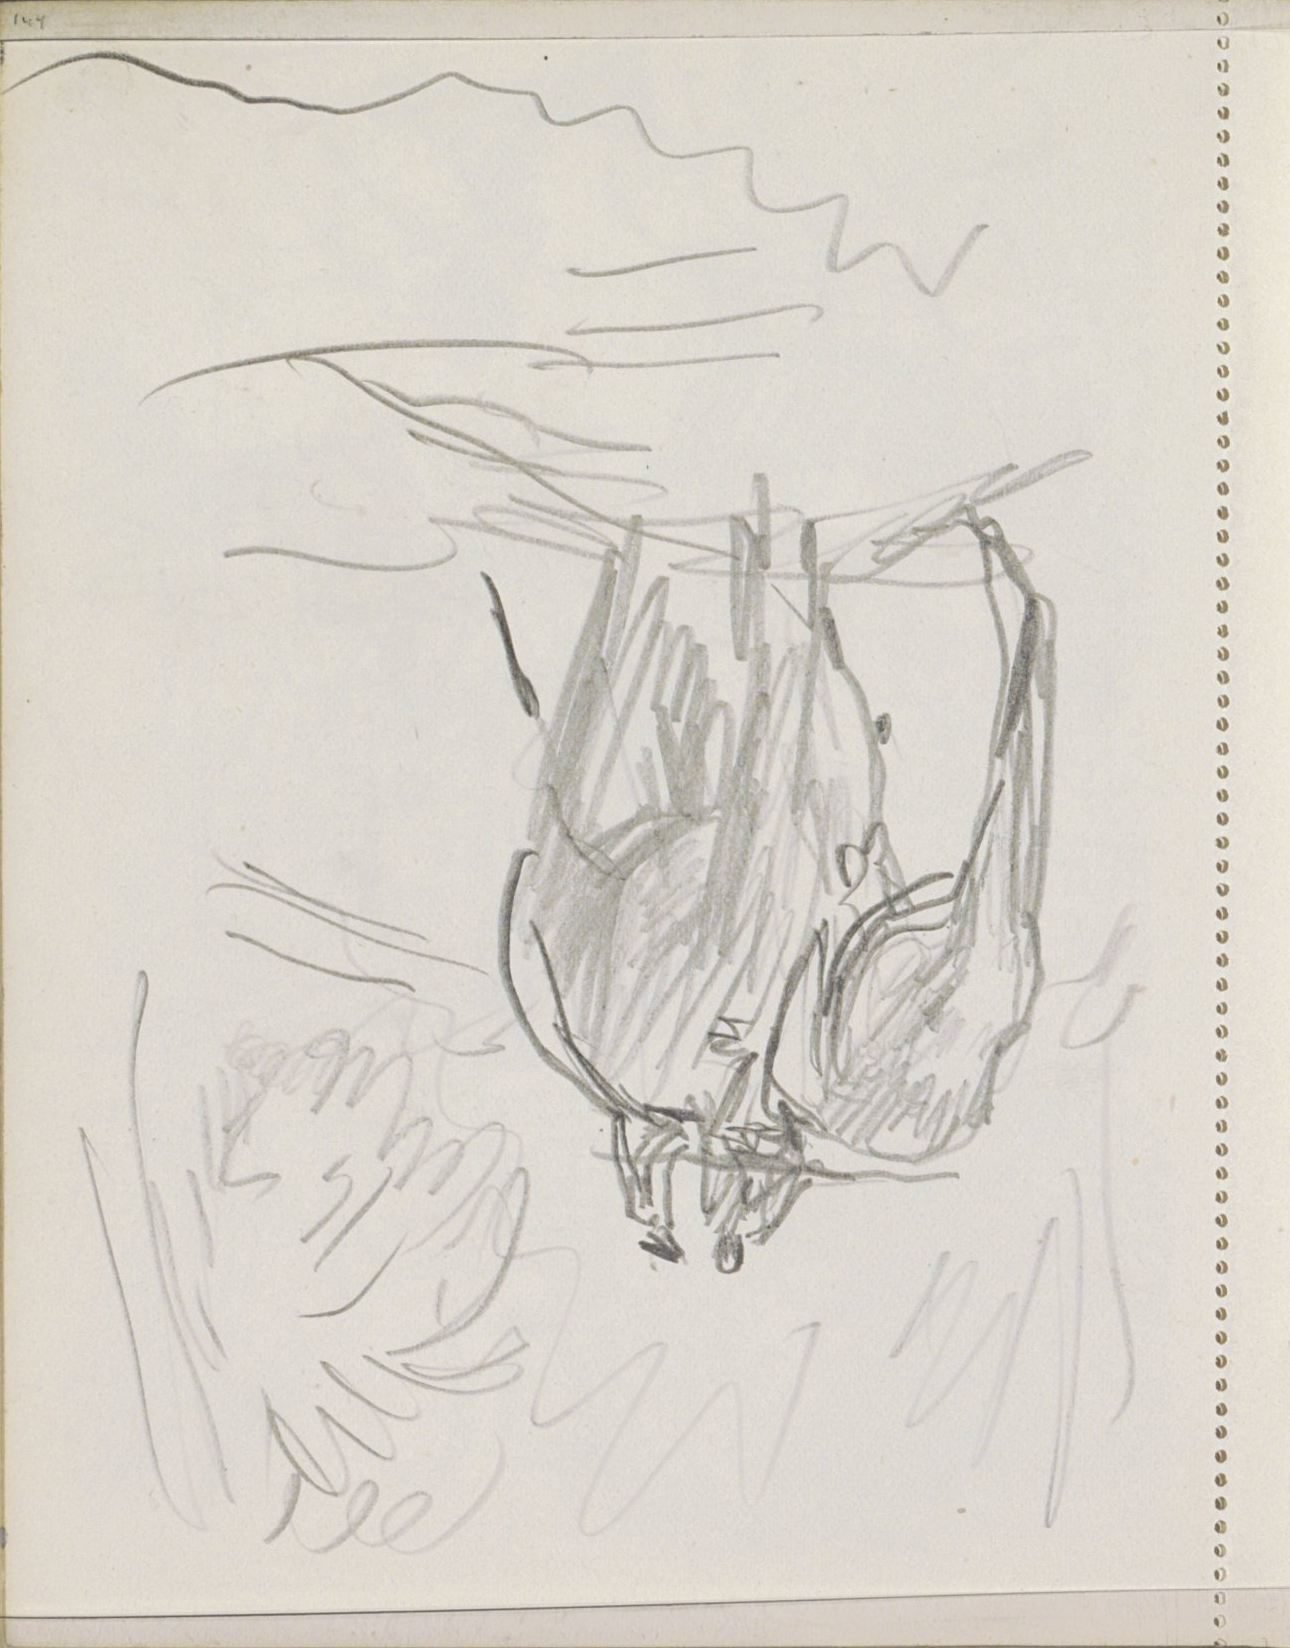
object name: sketchbook leaf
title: Twee figuren op een olifant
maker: marius bauer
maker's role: draughtsman, print maker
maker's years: 1867-1932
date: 1924-1925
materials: paper, pencil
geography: india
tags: sitting figure, jungle, trunked animals: elephant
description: Op de achtergrond gewassen, mogelijk het oerwoud van India. Pagina 144 uit een schetsboek met 75 bladen.